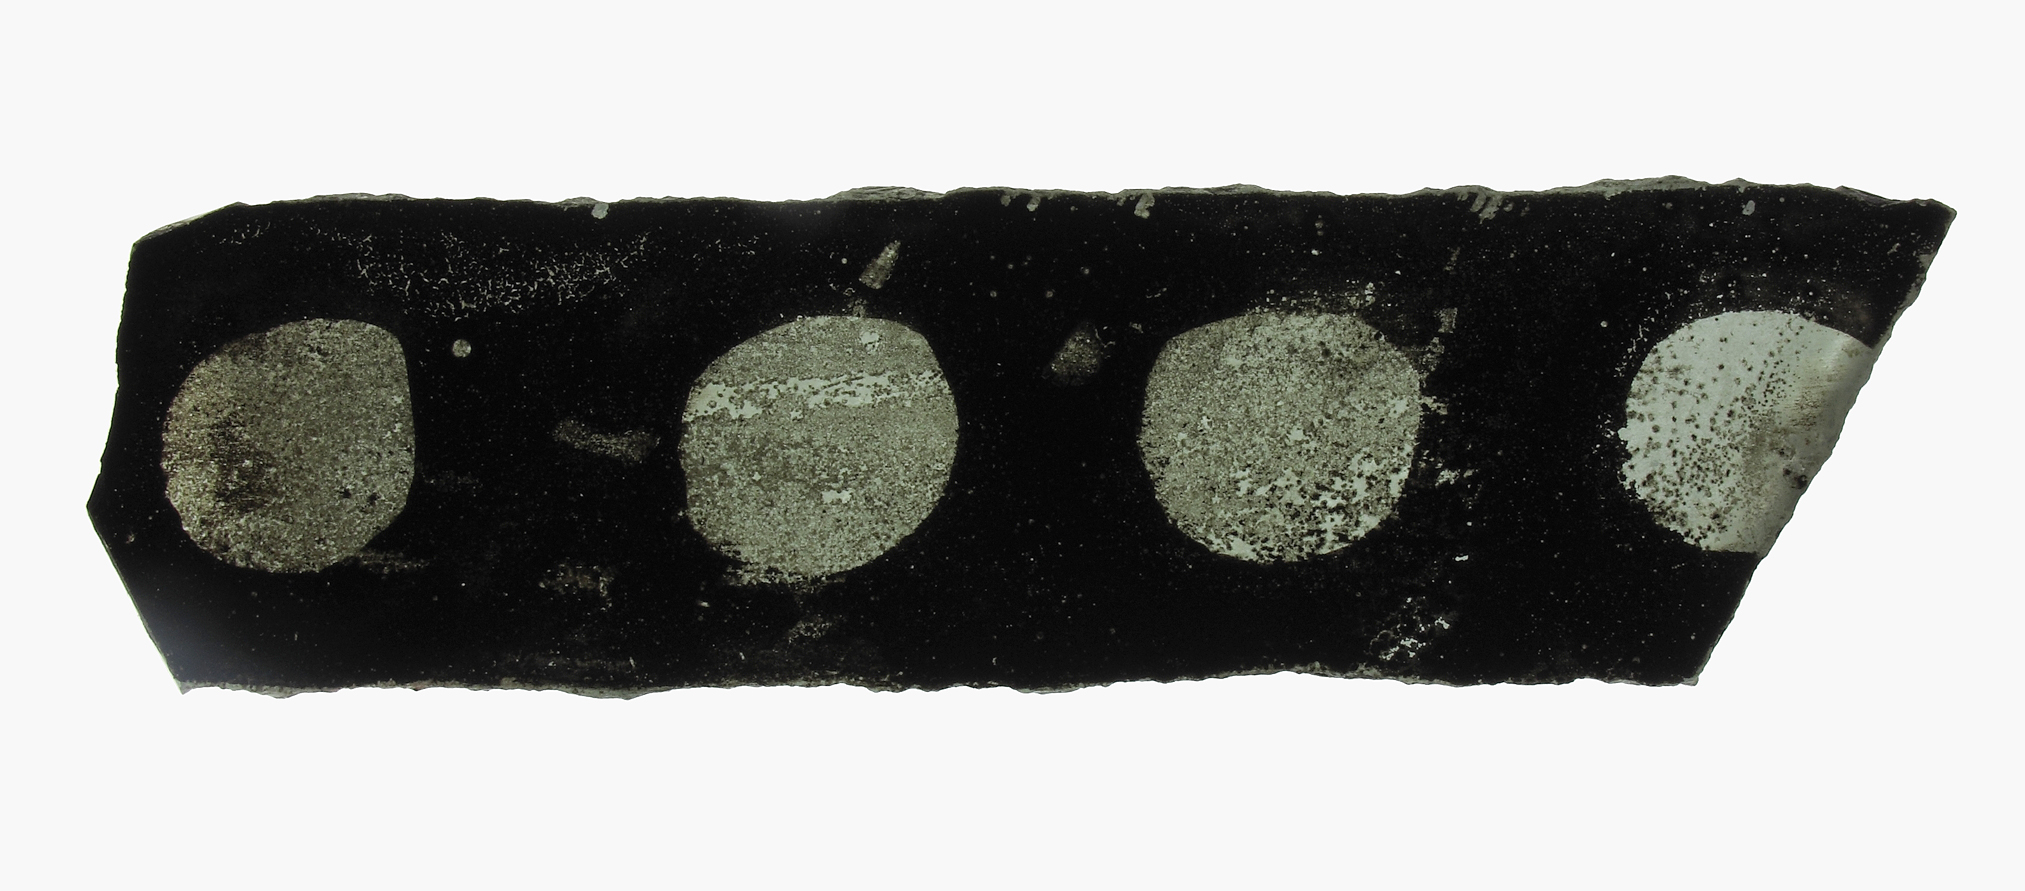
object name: fragment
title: Glass Fragment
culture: european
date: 1301-1500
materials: glass